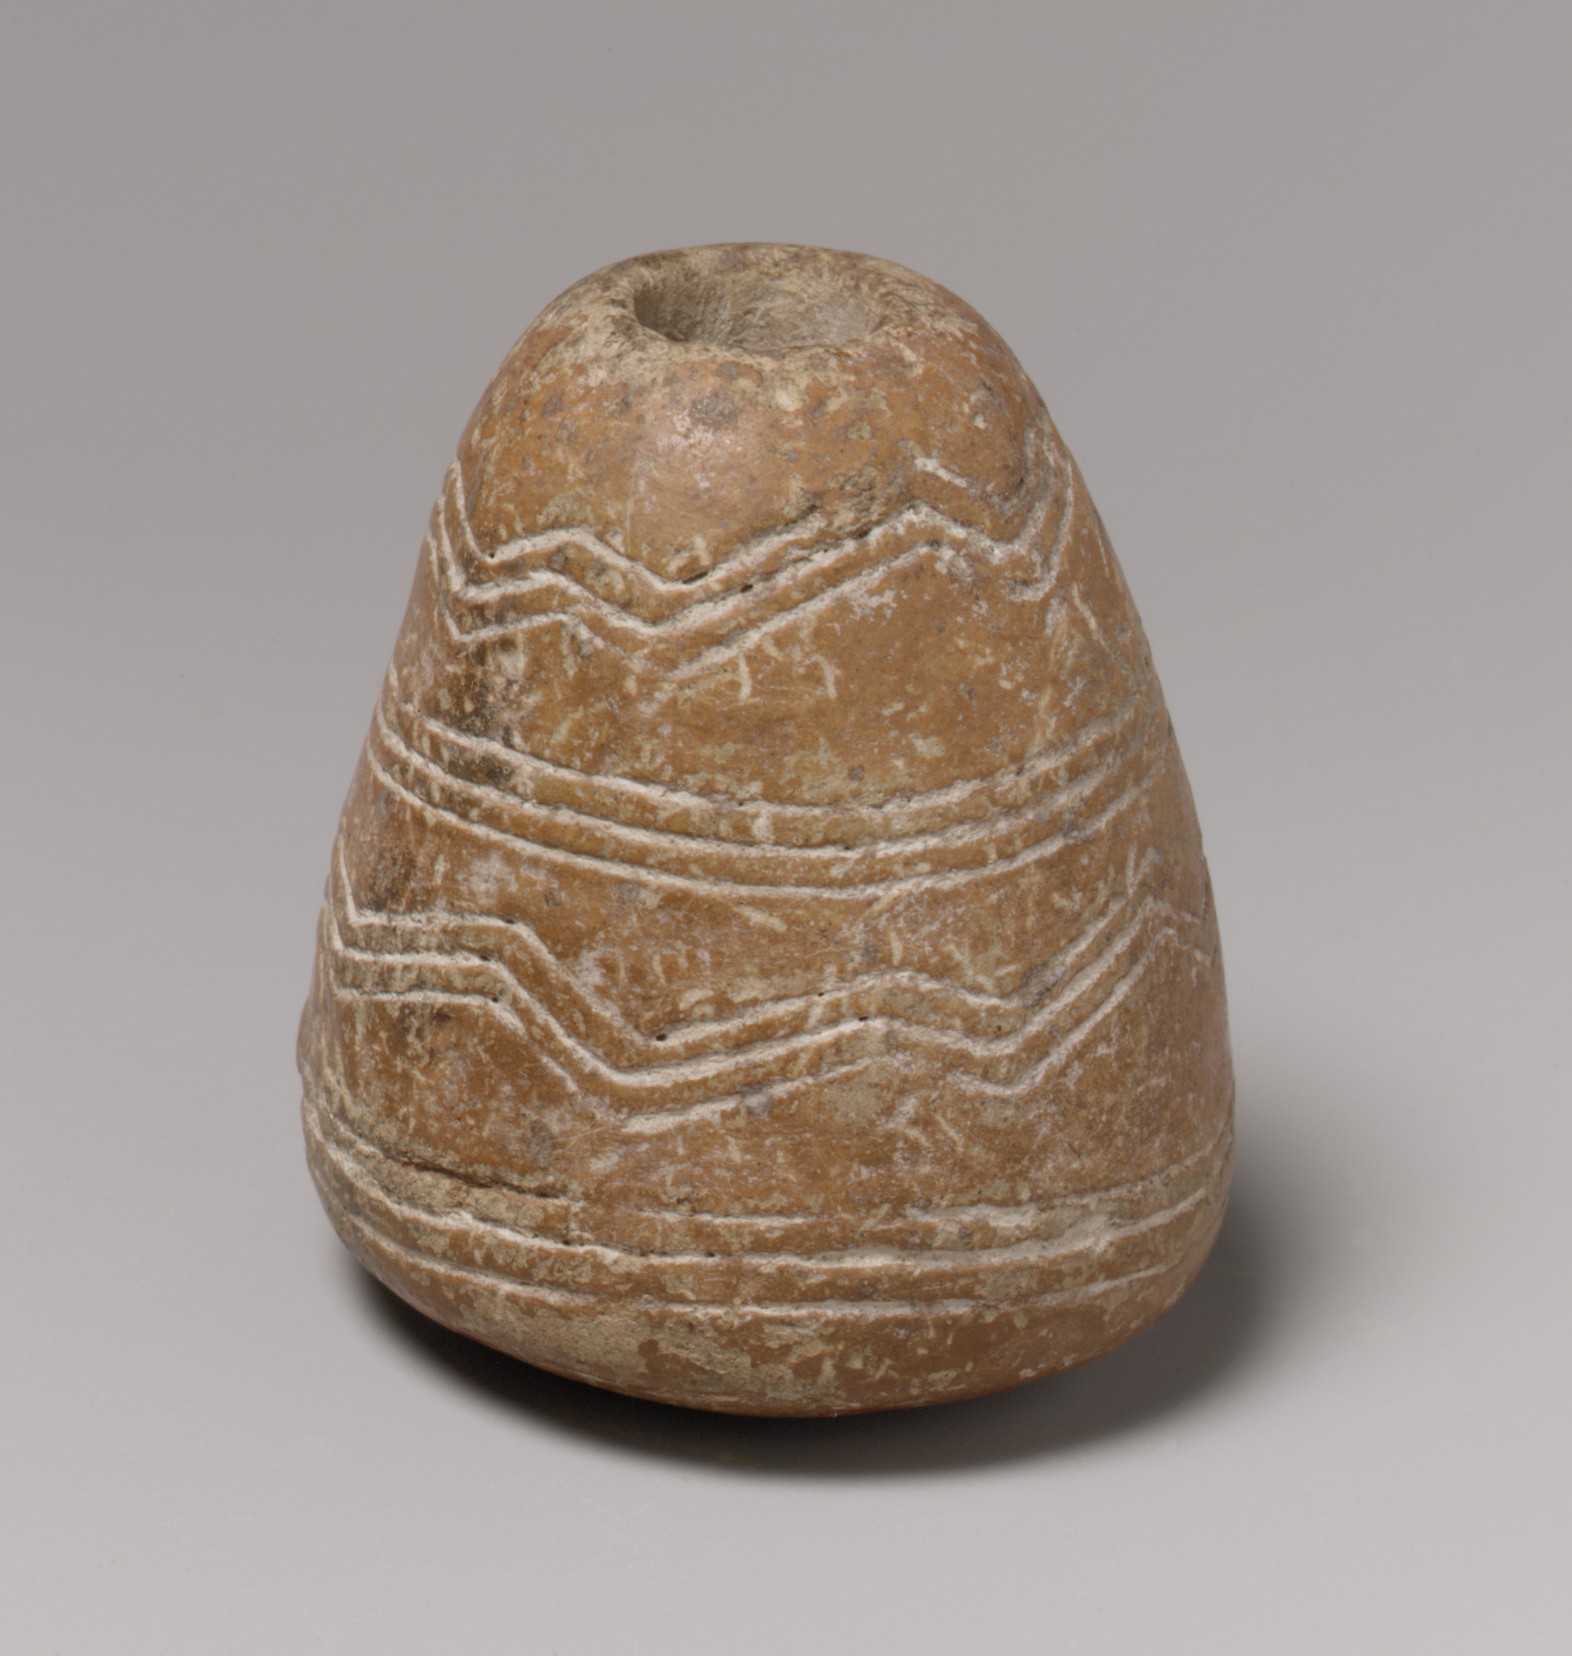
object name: spindle whorl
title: Terracotta spindle whorl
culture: cypriot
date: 2000-1725 BCE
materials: terracotta